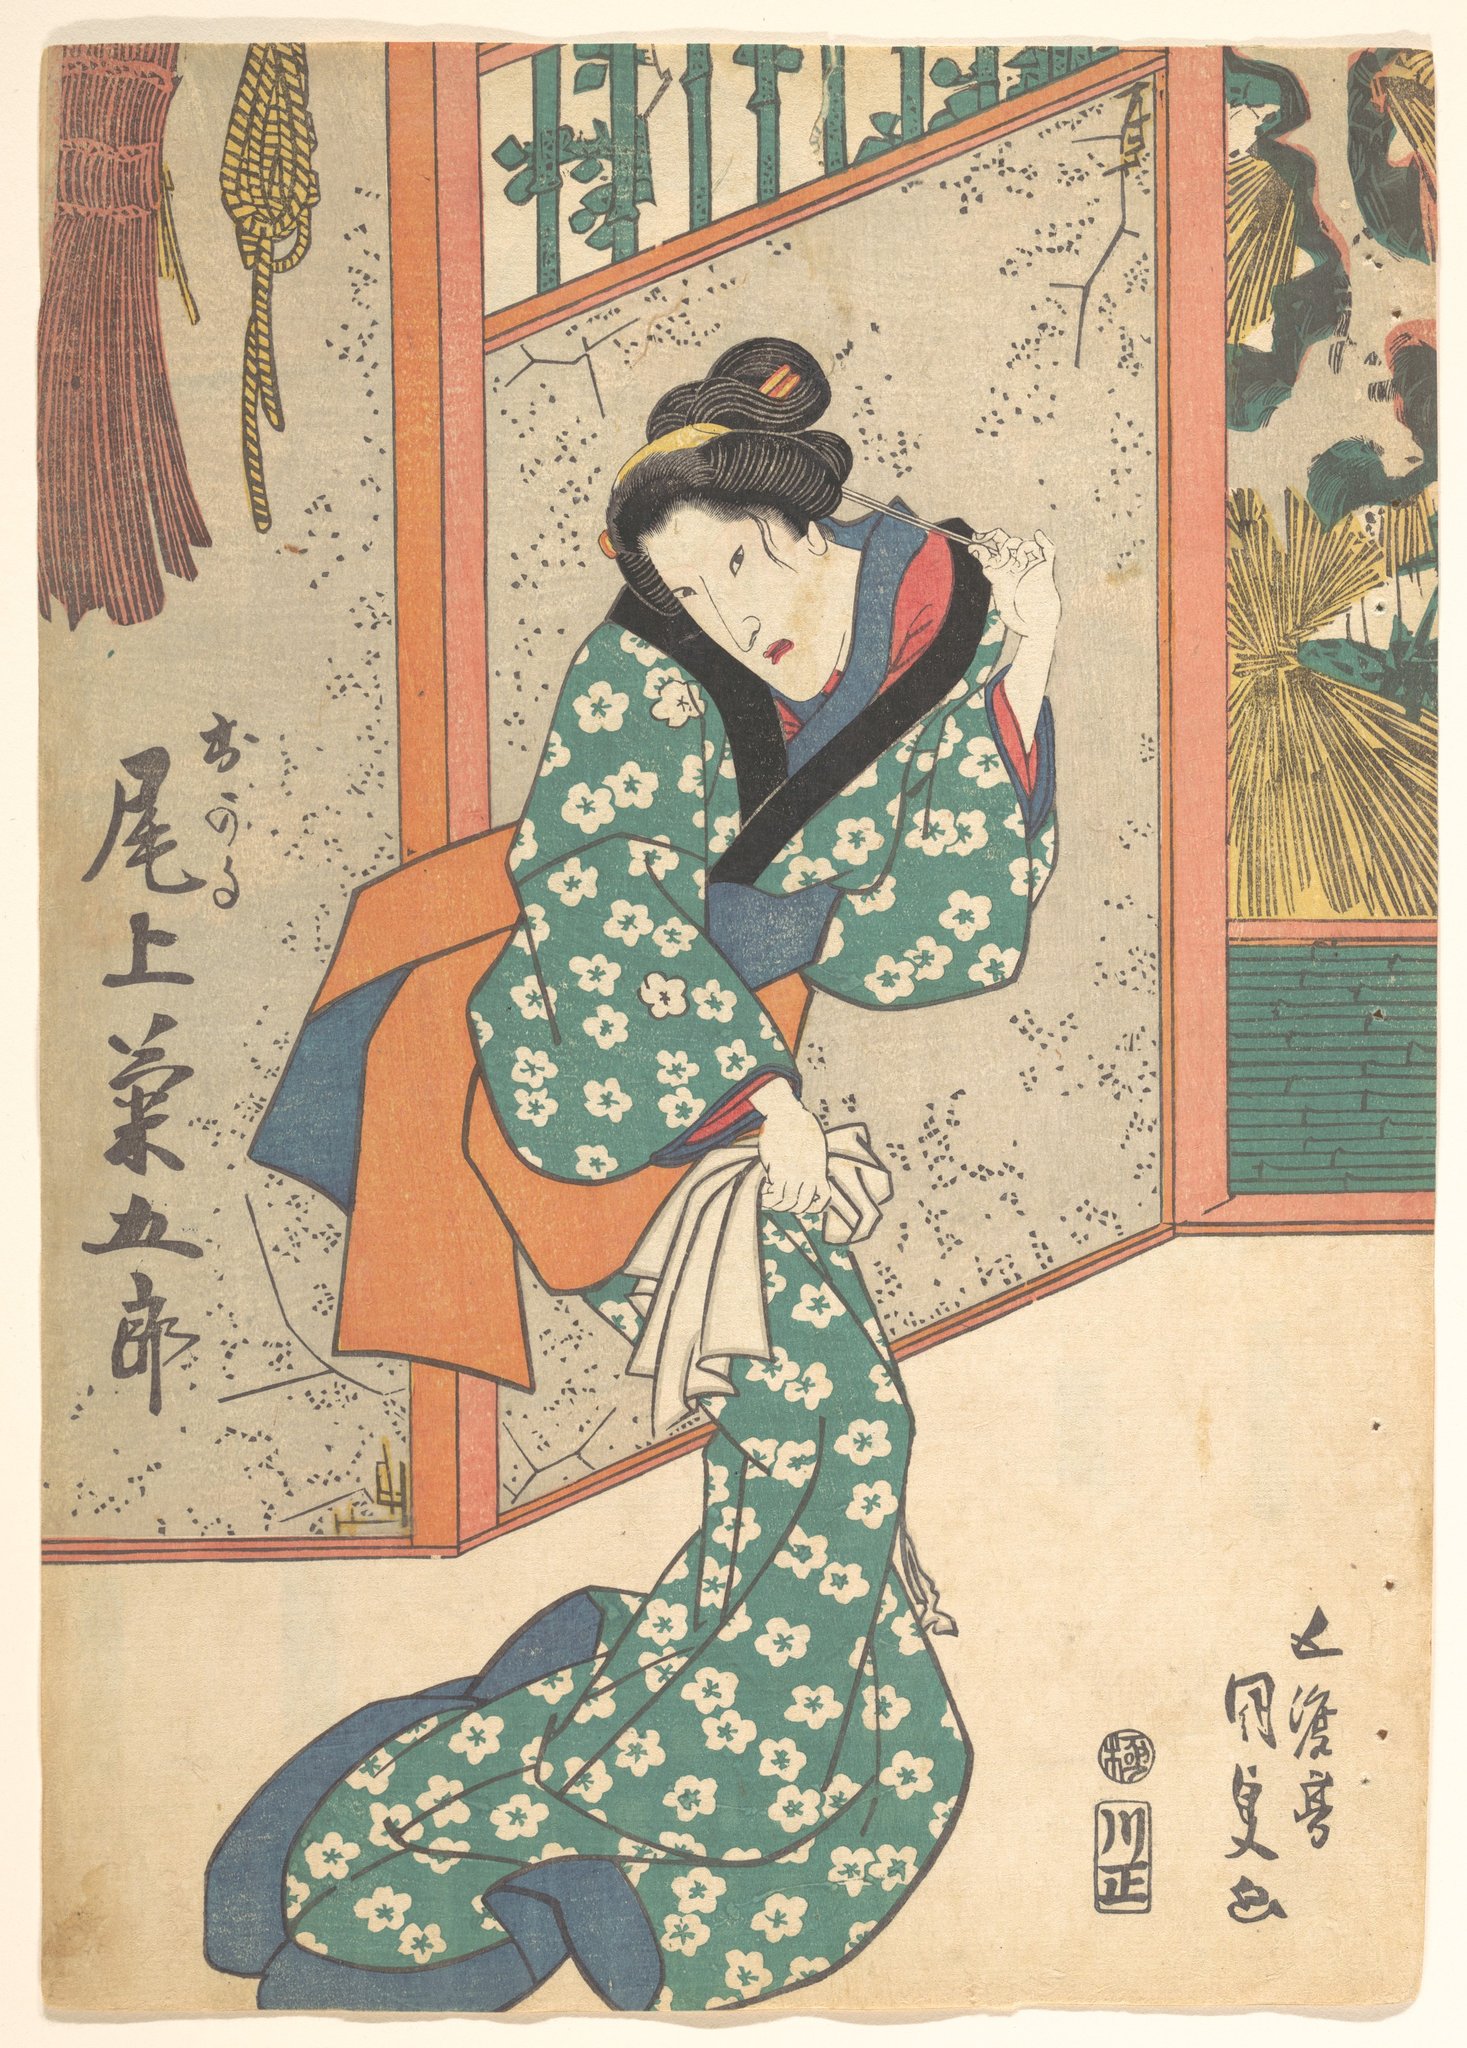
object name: print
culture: japanese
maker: utagawa kunisada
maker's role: artist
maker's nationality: japanese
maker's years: 1786-1864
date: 1801-1900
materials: ink, paper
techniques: woodblock print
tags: women